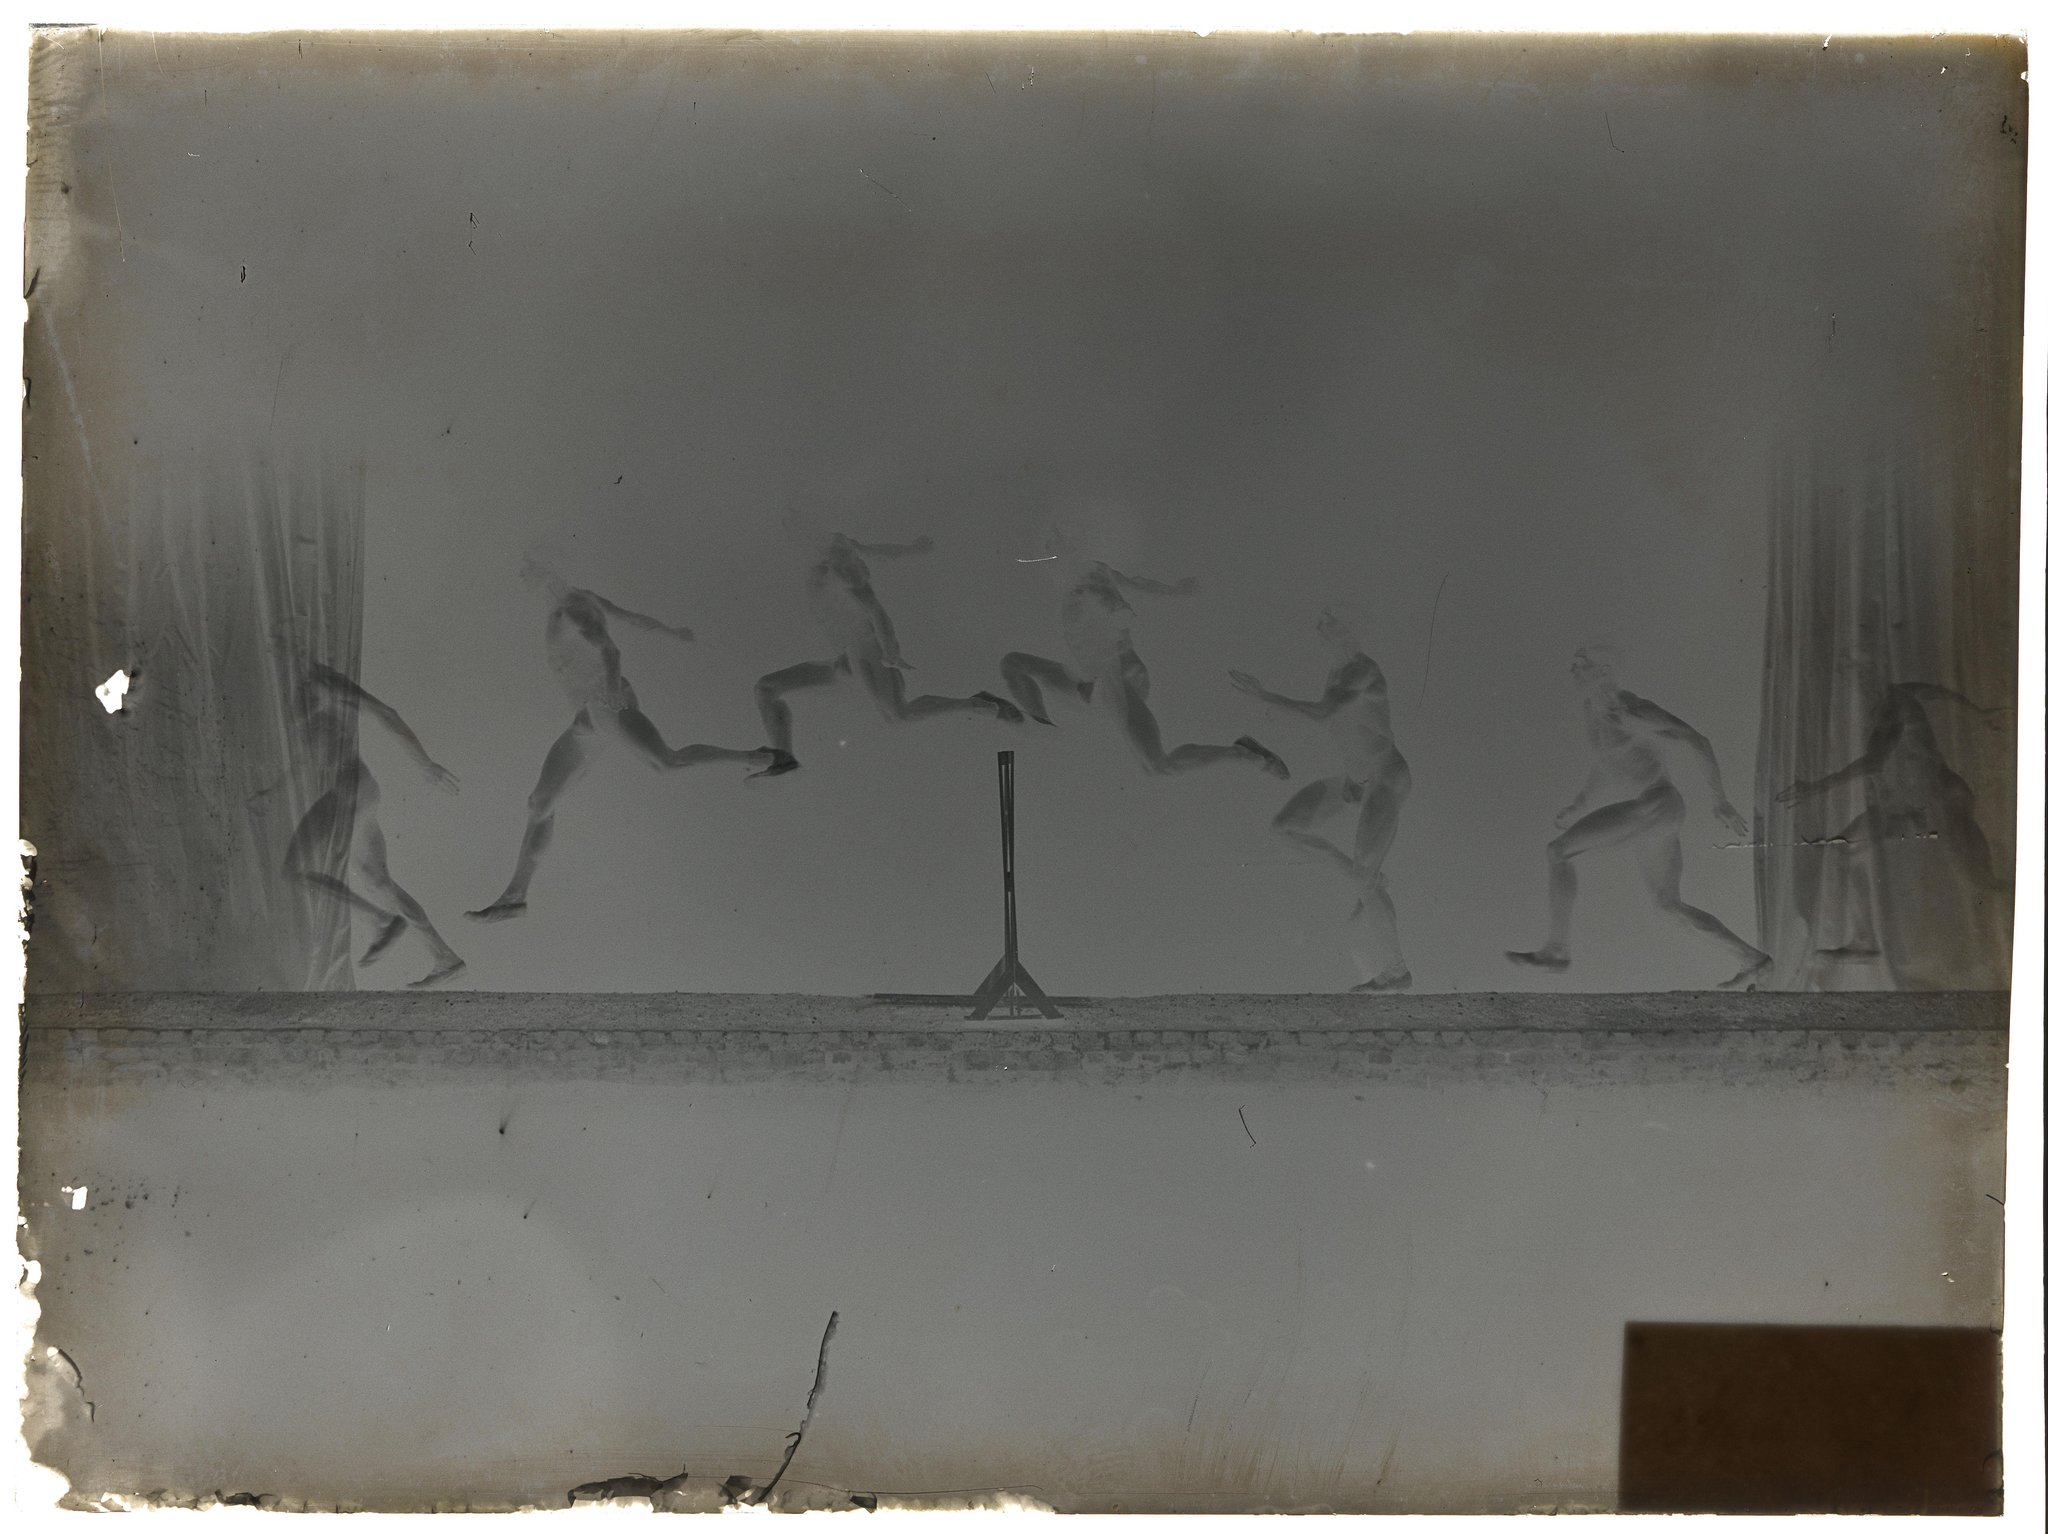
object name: glasnegatief, glasplaatnegatief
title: Man neemt horde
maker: étienne-jules marey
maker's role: fotograaf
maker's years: 1830-1904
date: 1882-1890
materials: glass, paper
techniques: gelatin glass negative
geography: france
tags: movements of the human body, adult man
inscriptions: inscription: ‘Ma 21’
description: Bij de negatieven zijn ook de duplicaatnegatieven en moderne afdrukken die voor de boekpublicatie vervaardigd zijn.